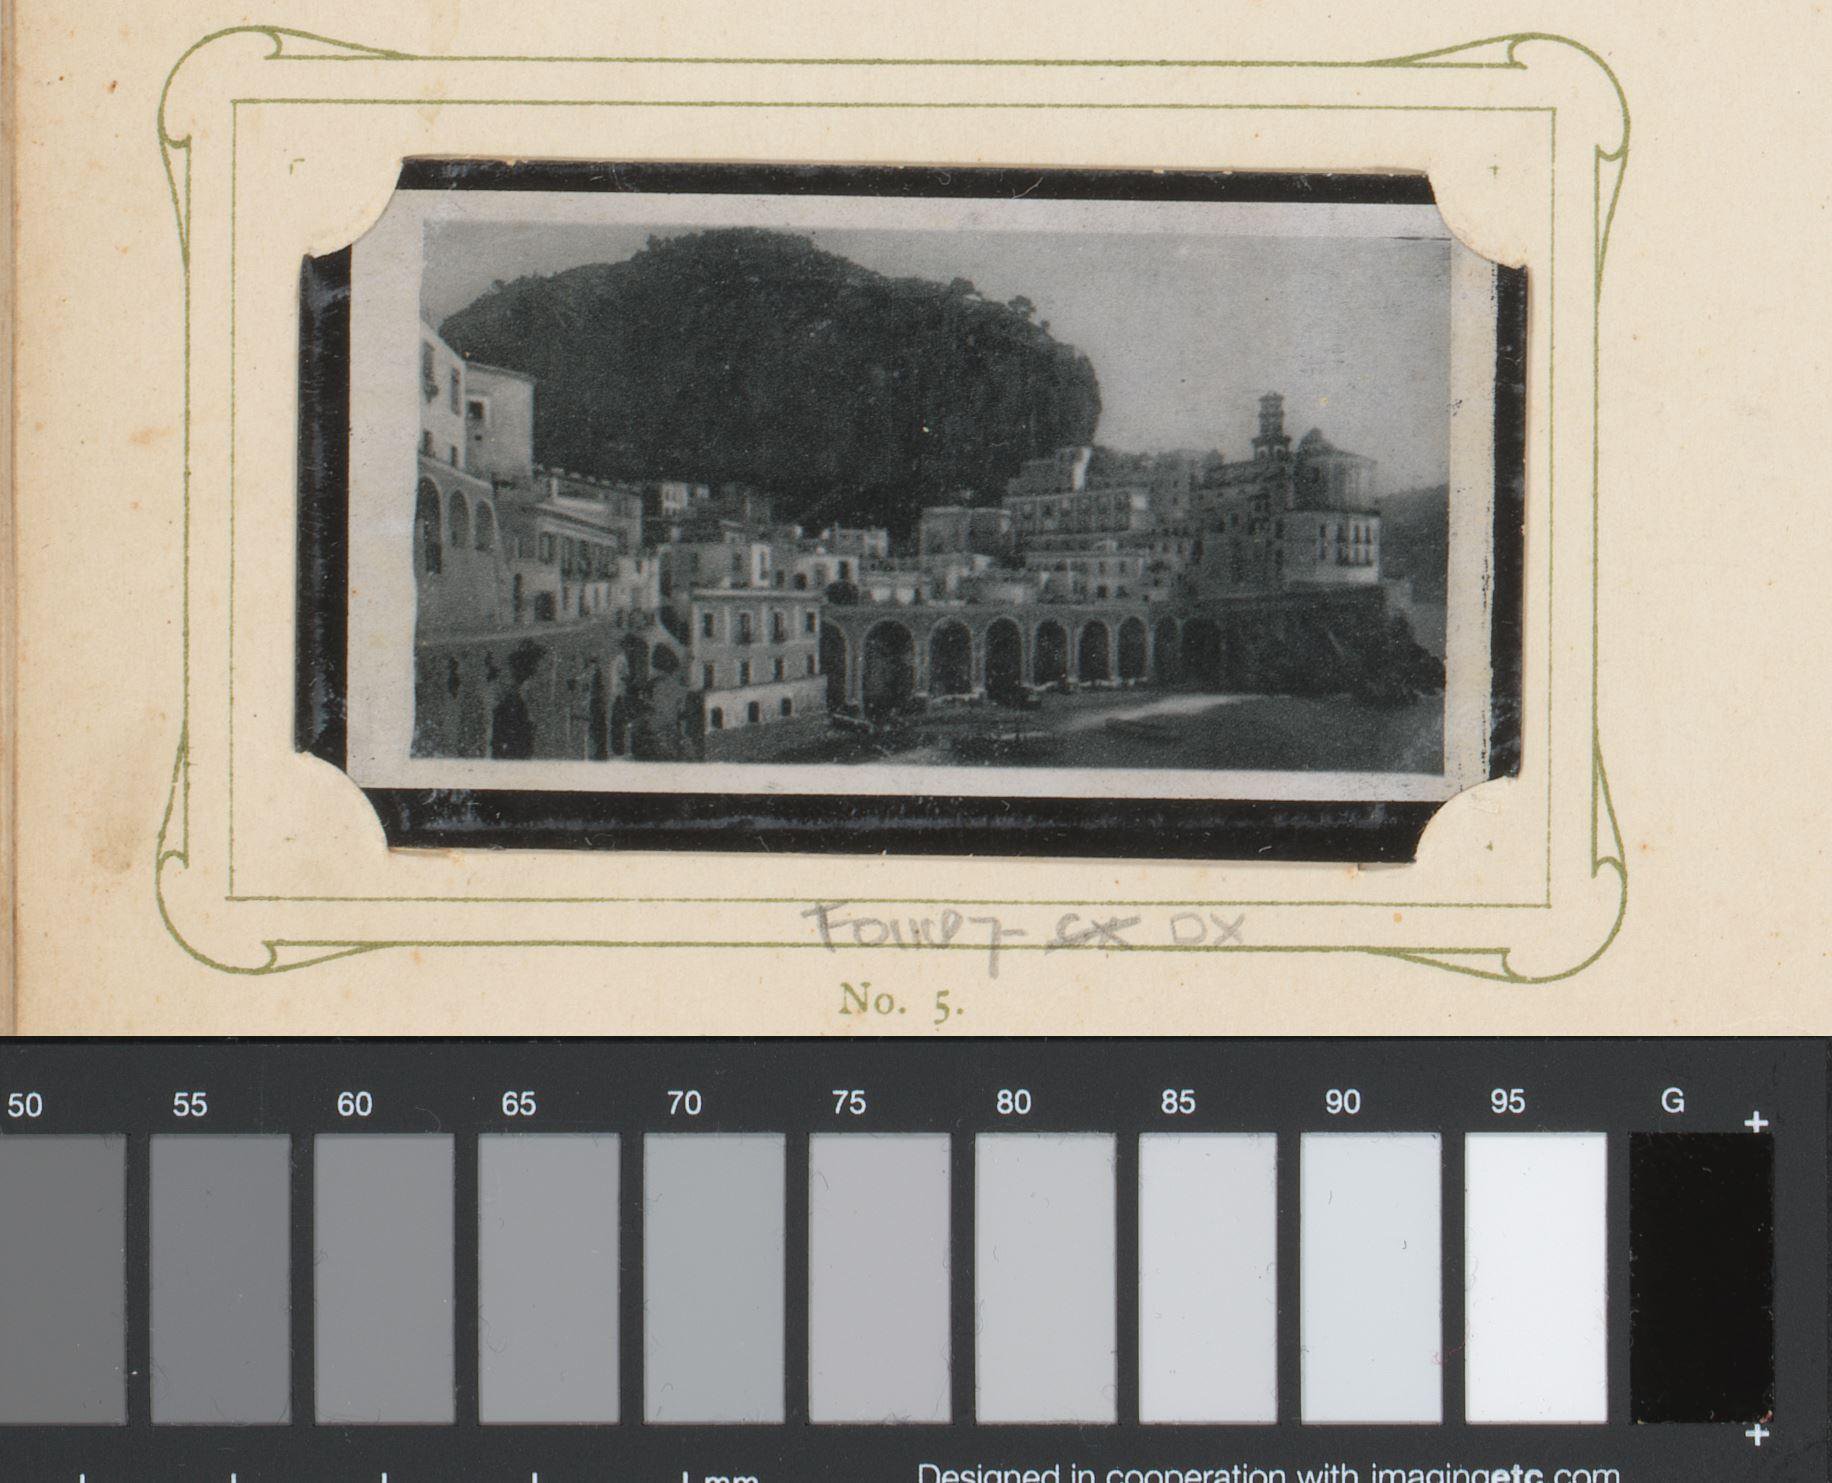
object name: photomechanical print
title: Gezicht op Atrani, Italië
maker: Anonymous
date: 1905-1906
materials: paper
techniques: photograph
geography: atrani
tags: prospect of village, silhouette of village, atrani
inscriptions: inscription: ‘No. 5./ Atrani.’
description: Deze prent maakt deel uit van een album.